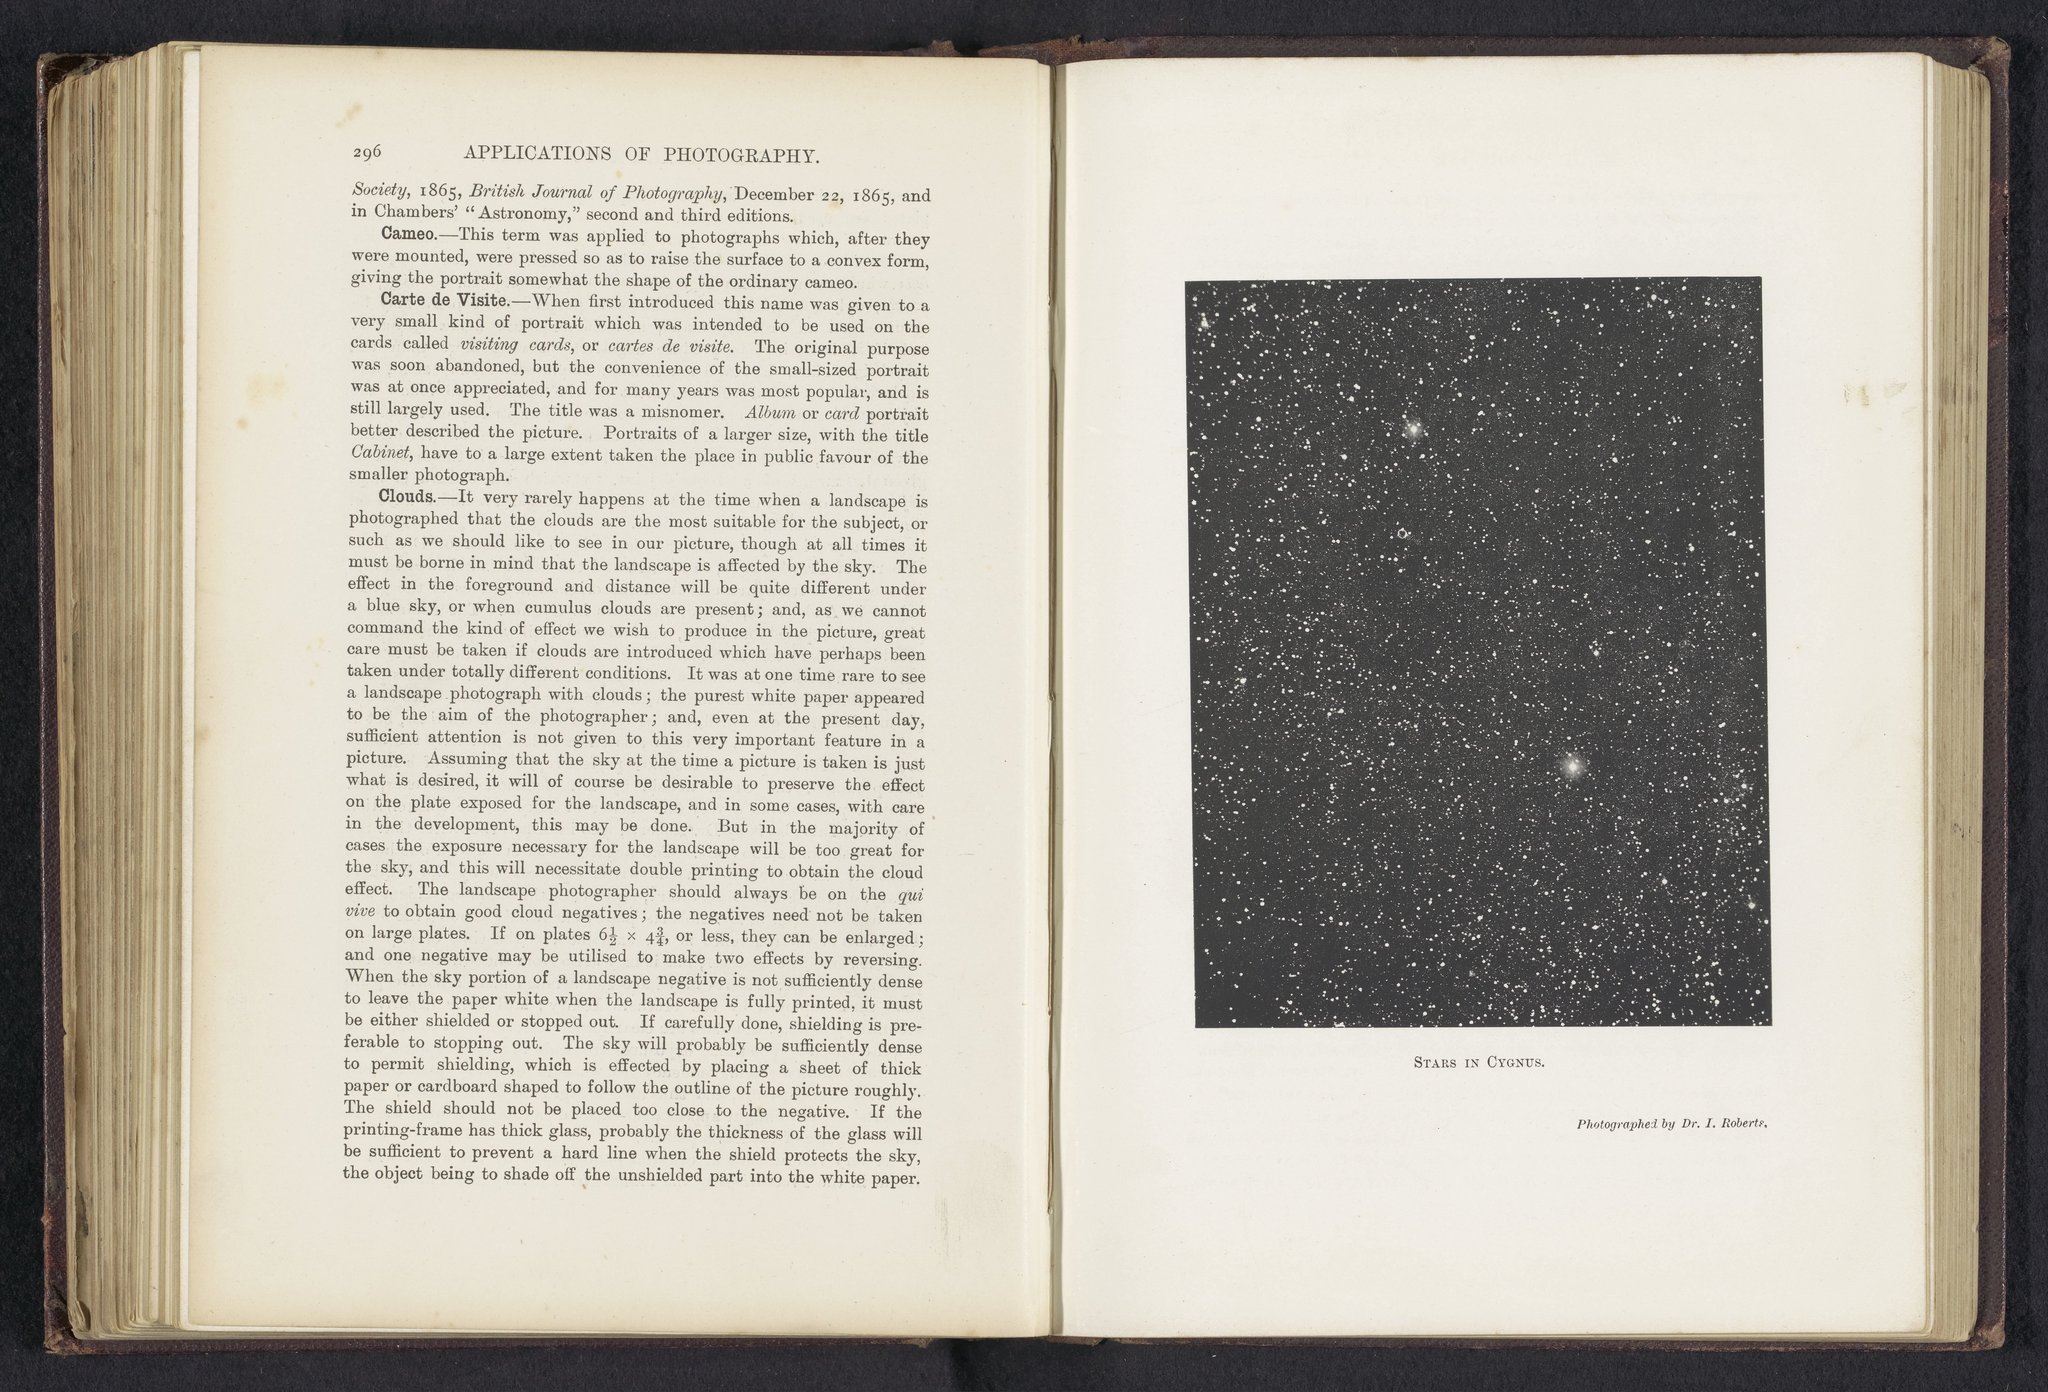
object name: page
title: Stars in Cygnus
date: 1889-1899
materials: paper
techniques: autotype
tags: stars and constellations